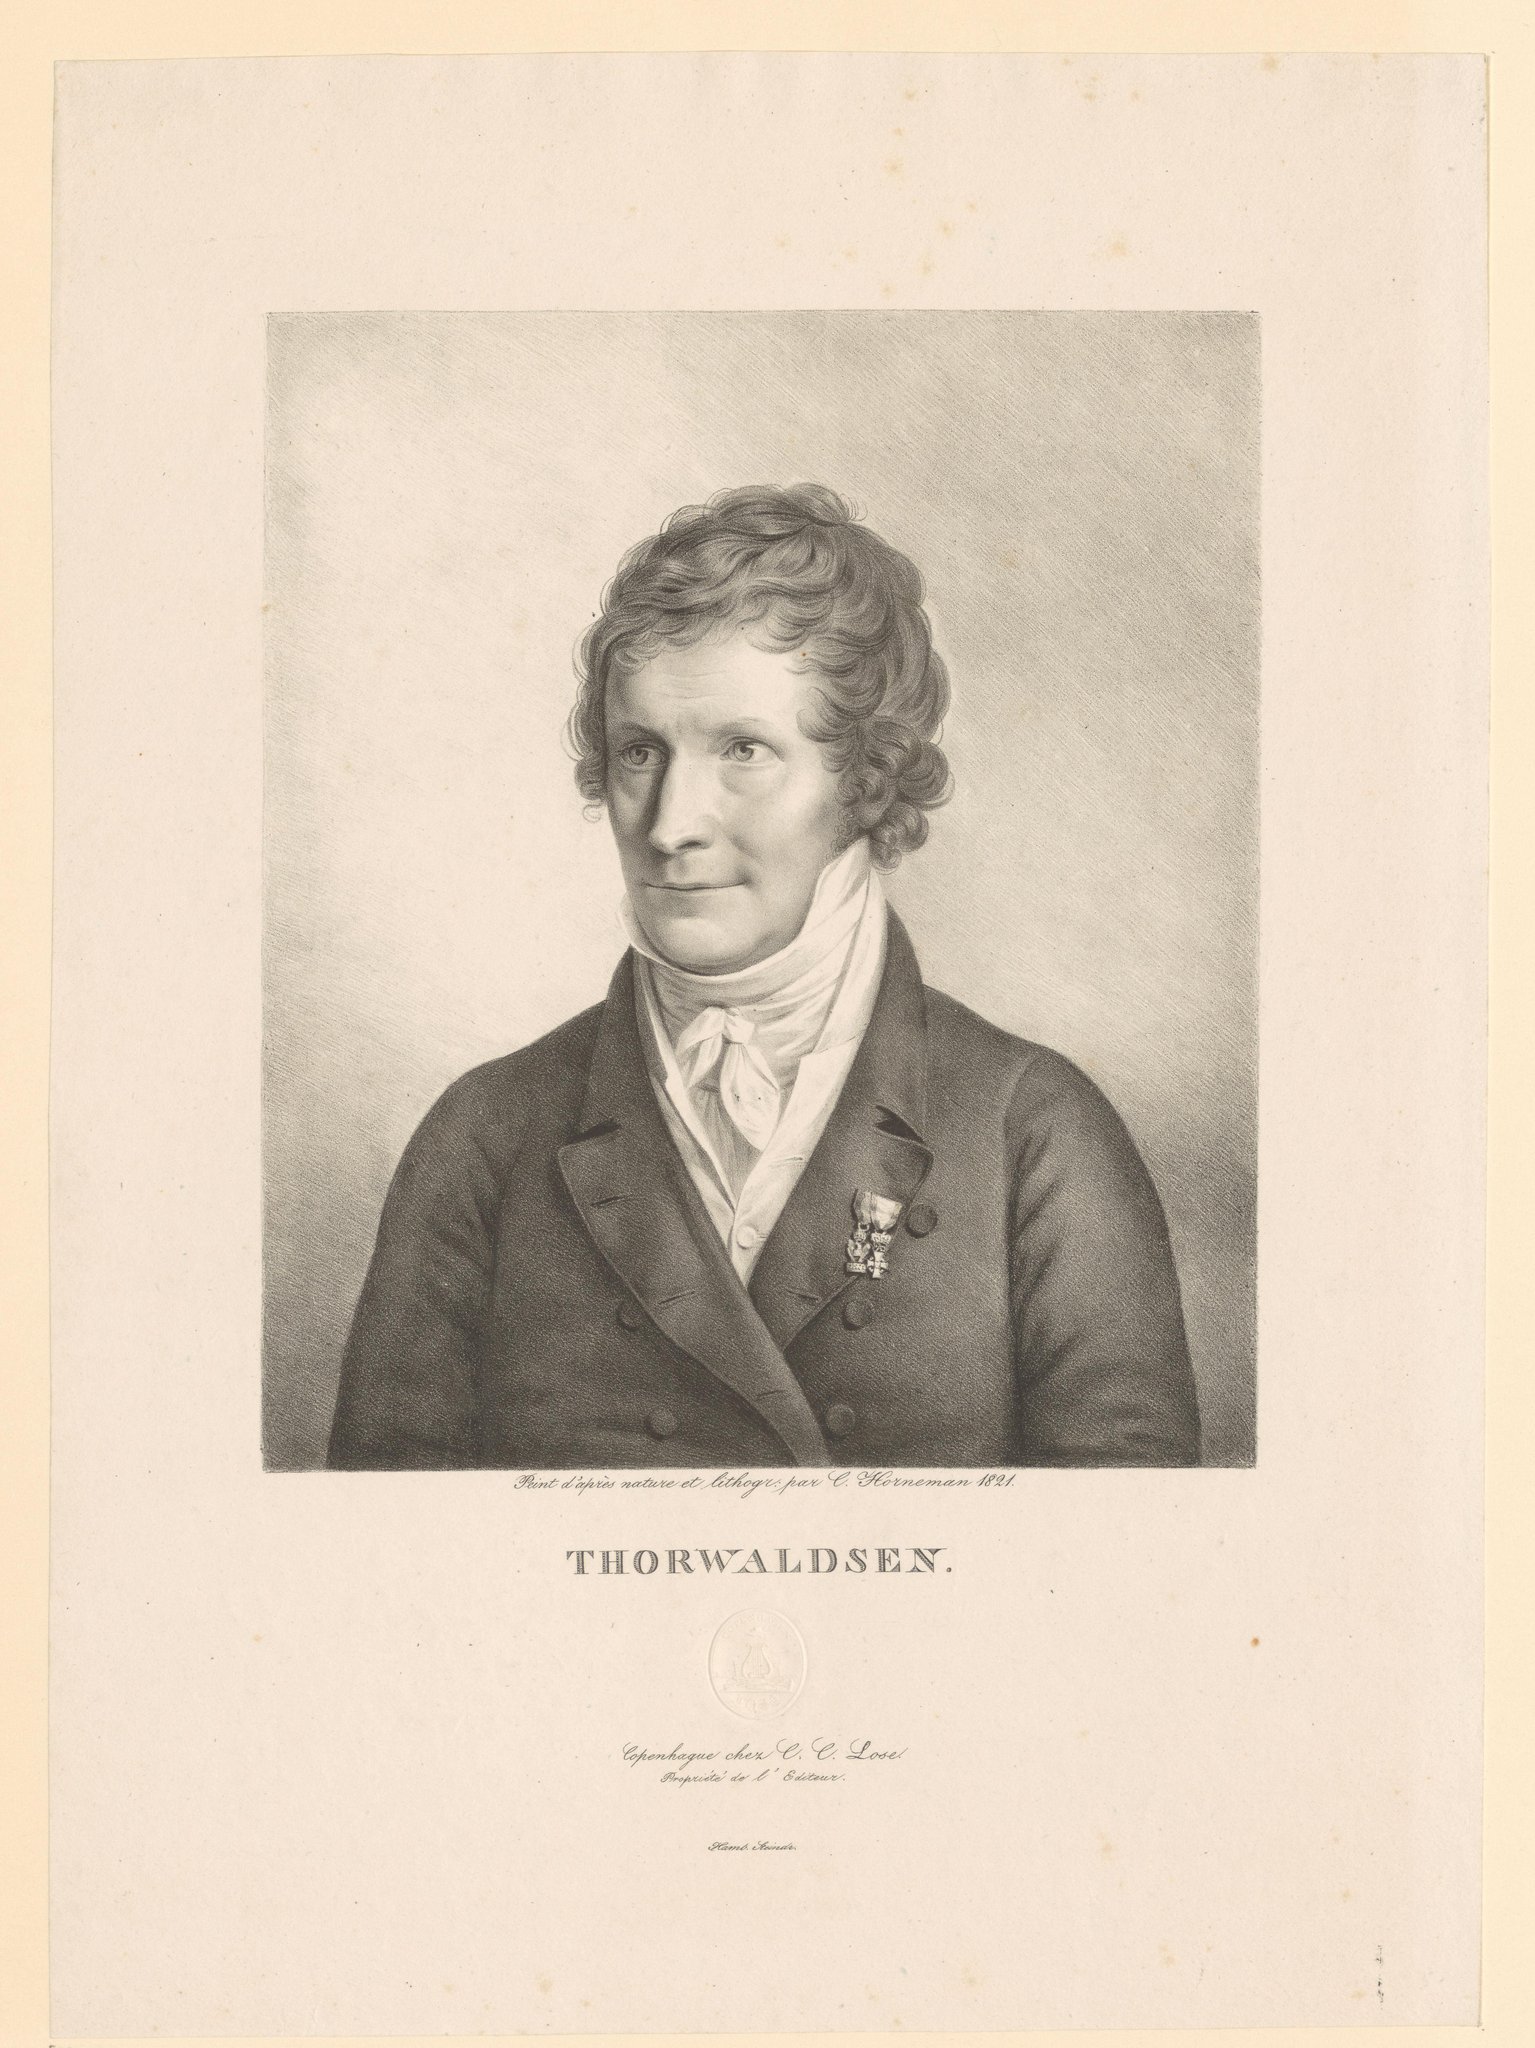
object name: print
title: Thorwaldsen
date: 1821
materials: paper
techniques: lithograph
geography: hamburg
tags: copenhagen (city), draughtsman, bertel thorvaldsen, adult man, historical persons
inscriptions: collector's mark: Lugt 2760, collector's mark: Lugt 2228, mark: ‘M[J/P]’, check stamp: ‘Copenhagen, Lose’